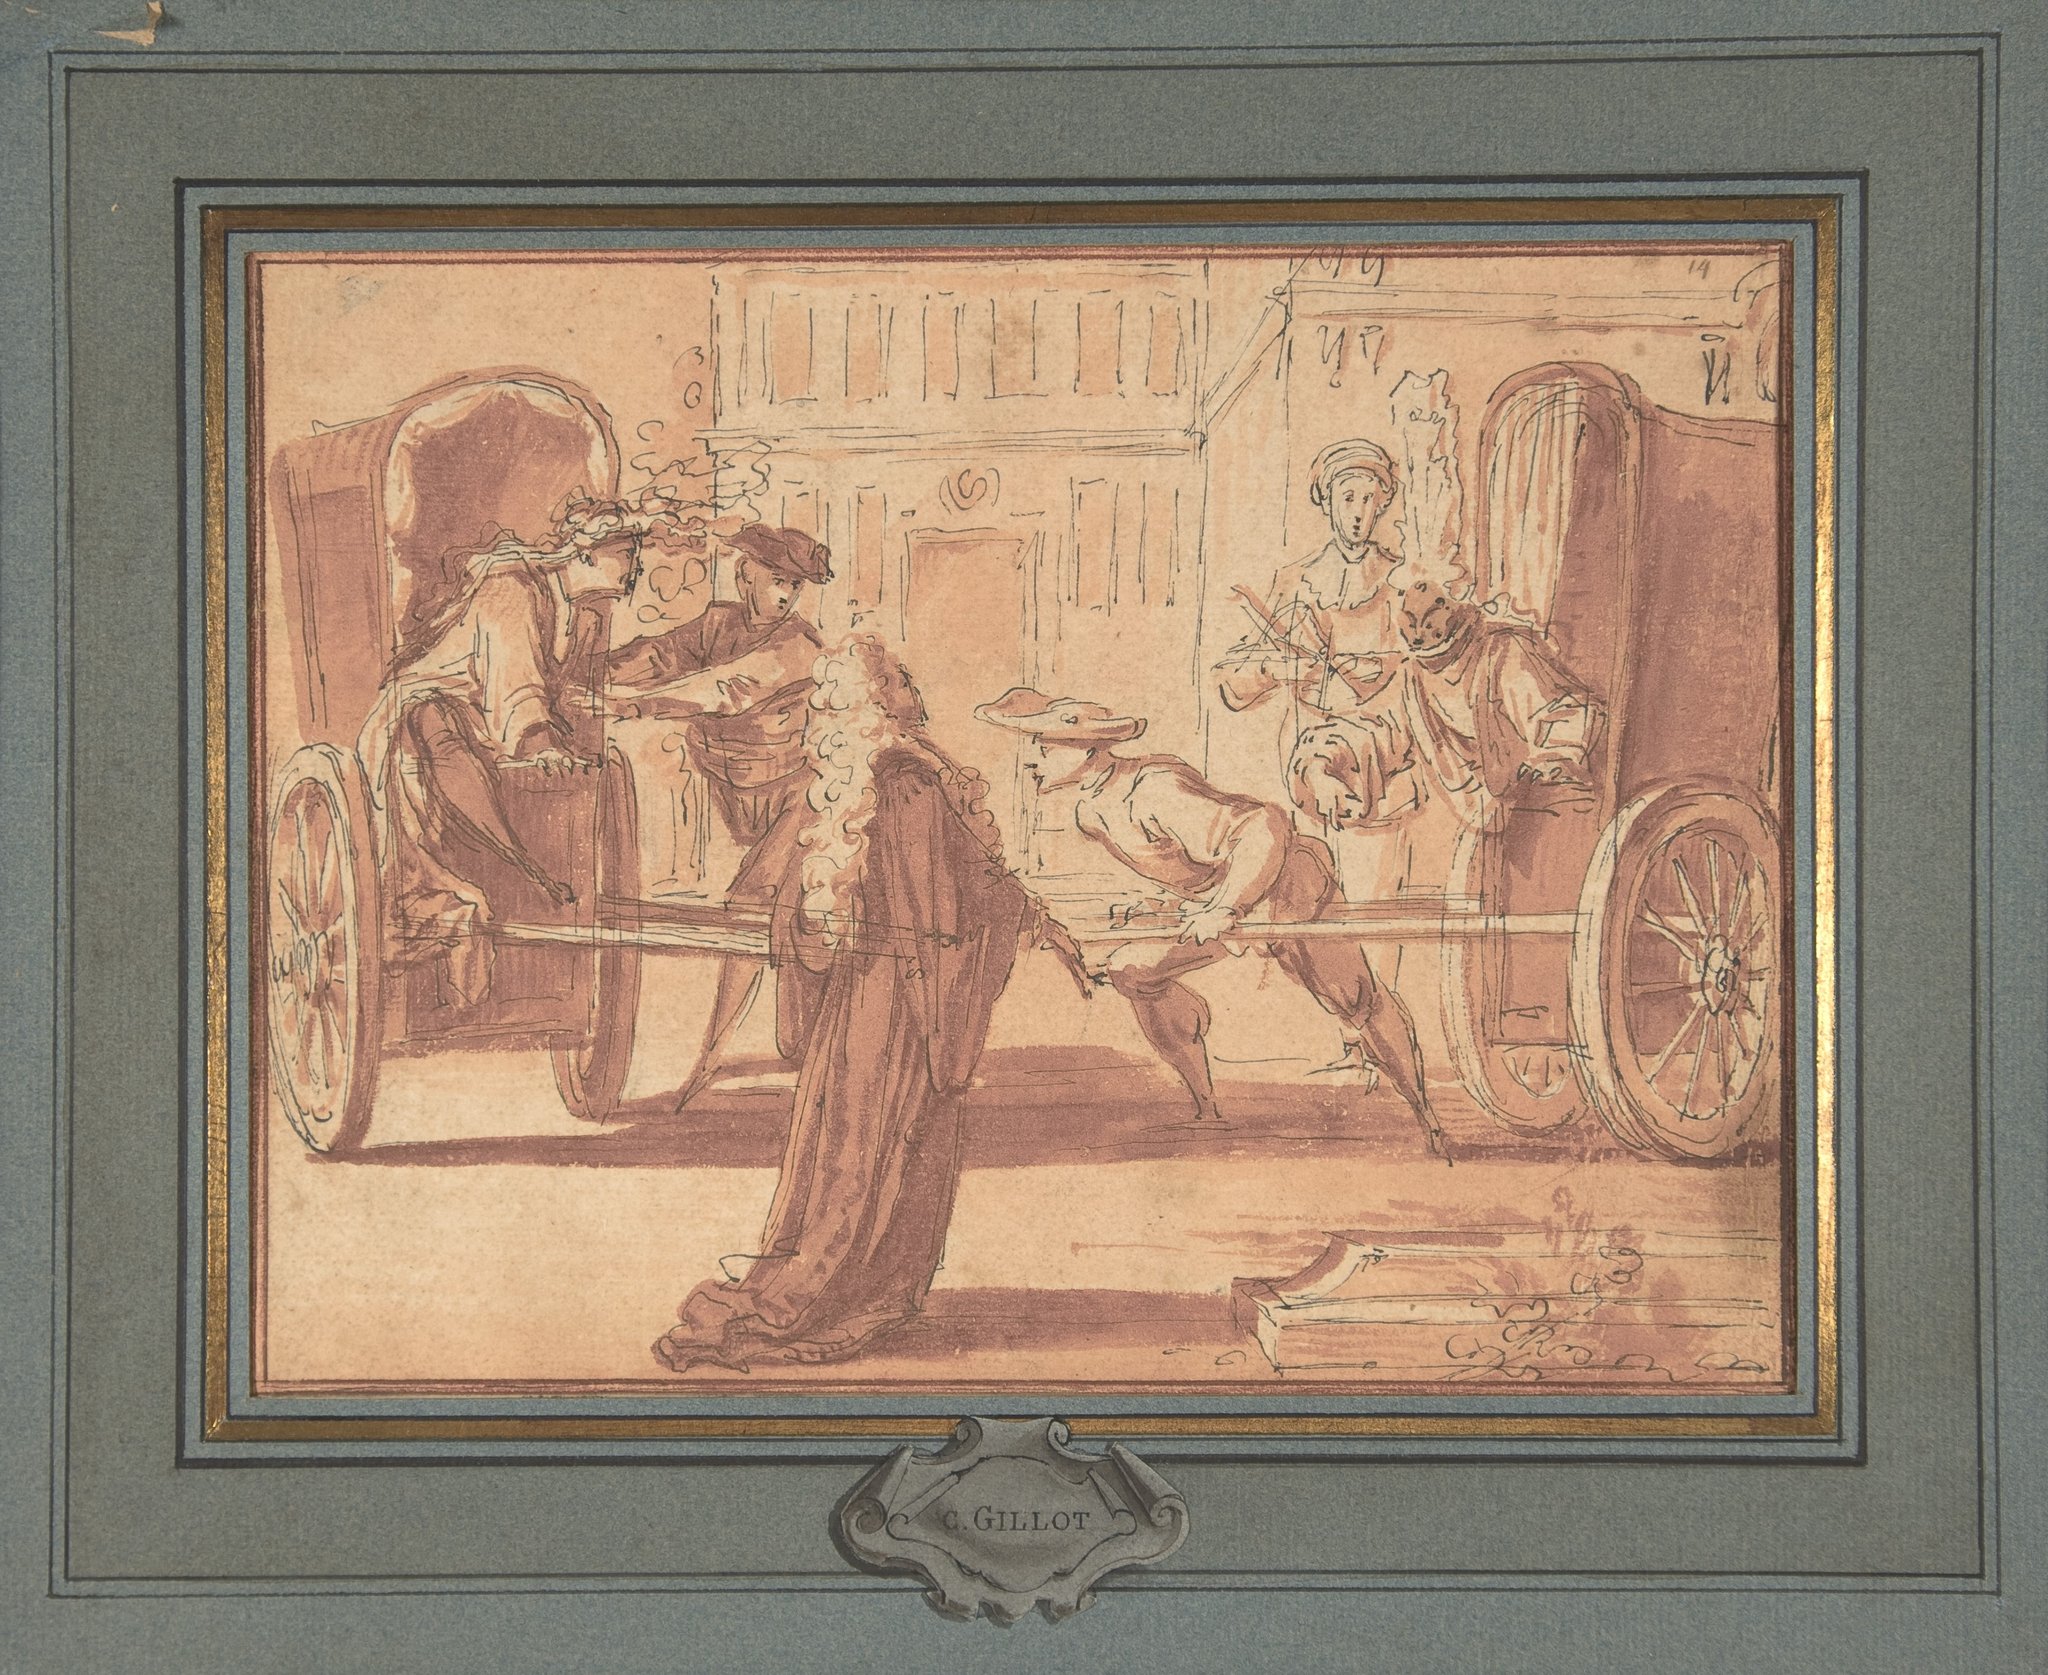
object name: drawing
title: La scène des deux carrosses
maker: claude gillot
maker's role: artist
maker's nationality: french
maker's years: 1673-1722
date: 1712-1716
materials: ink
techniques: brush, pen, wash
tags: men,carriages